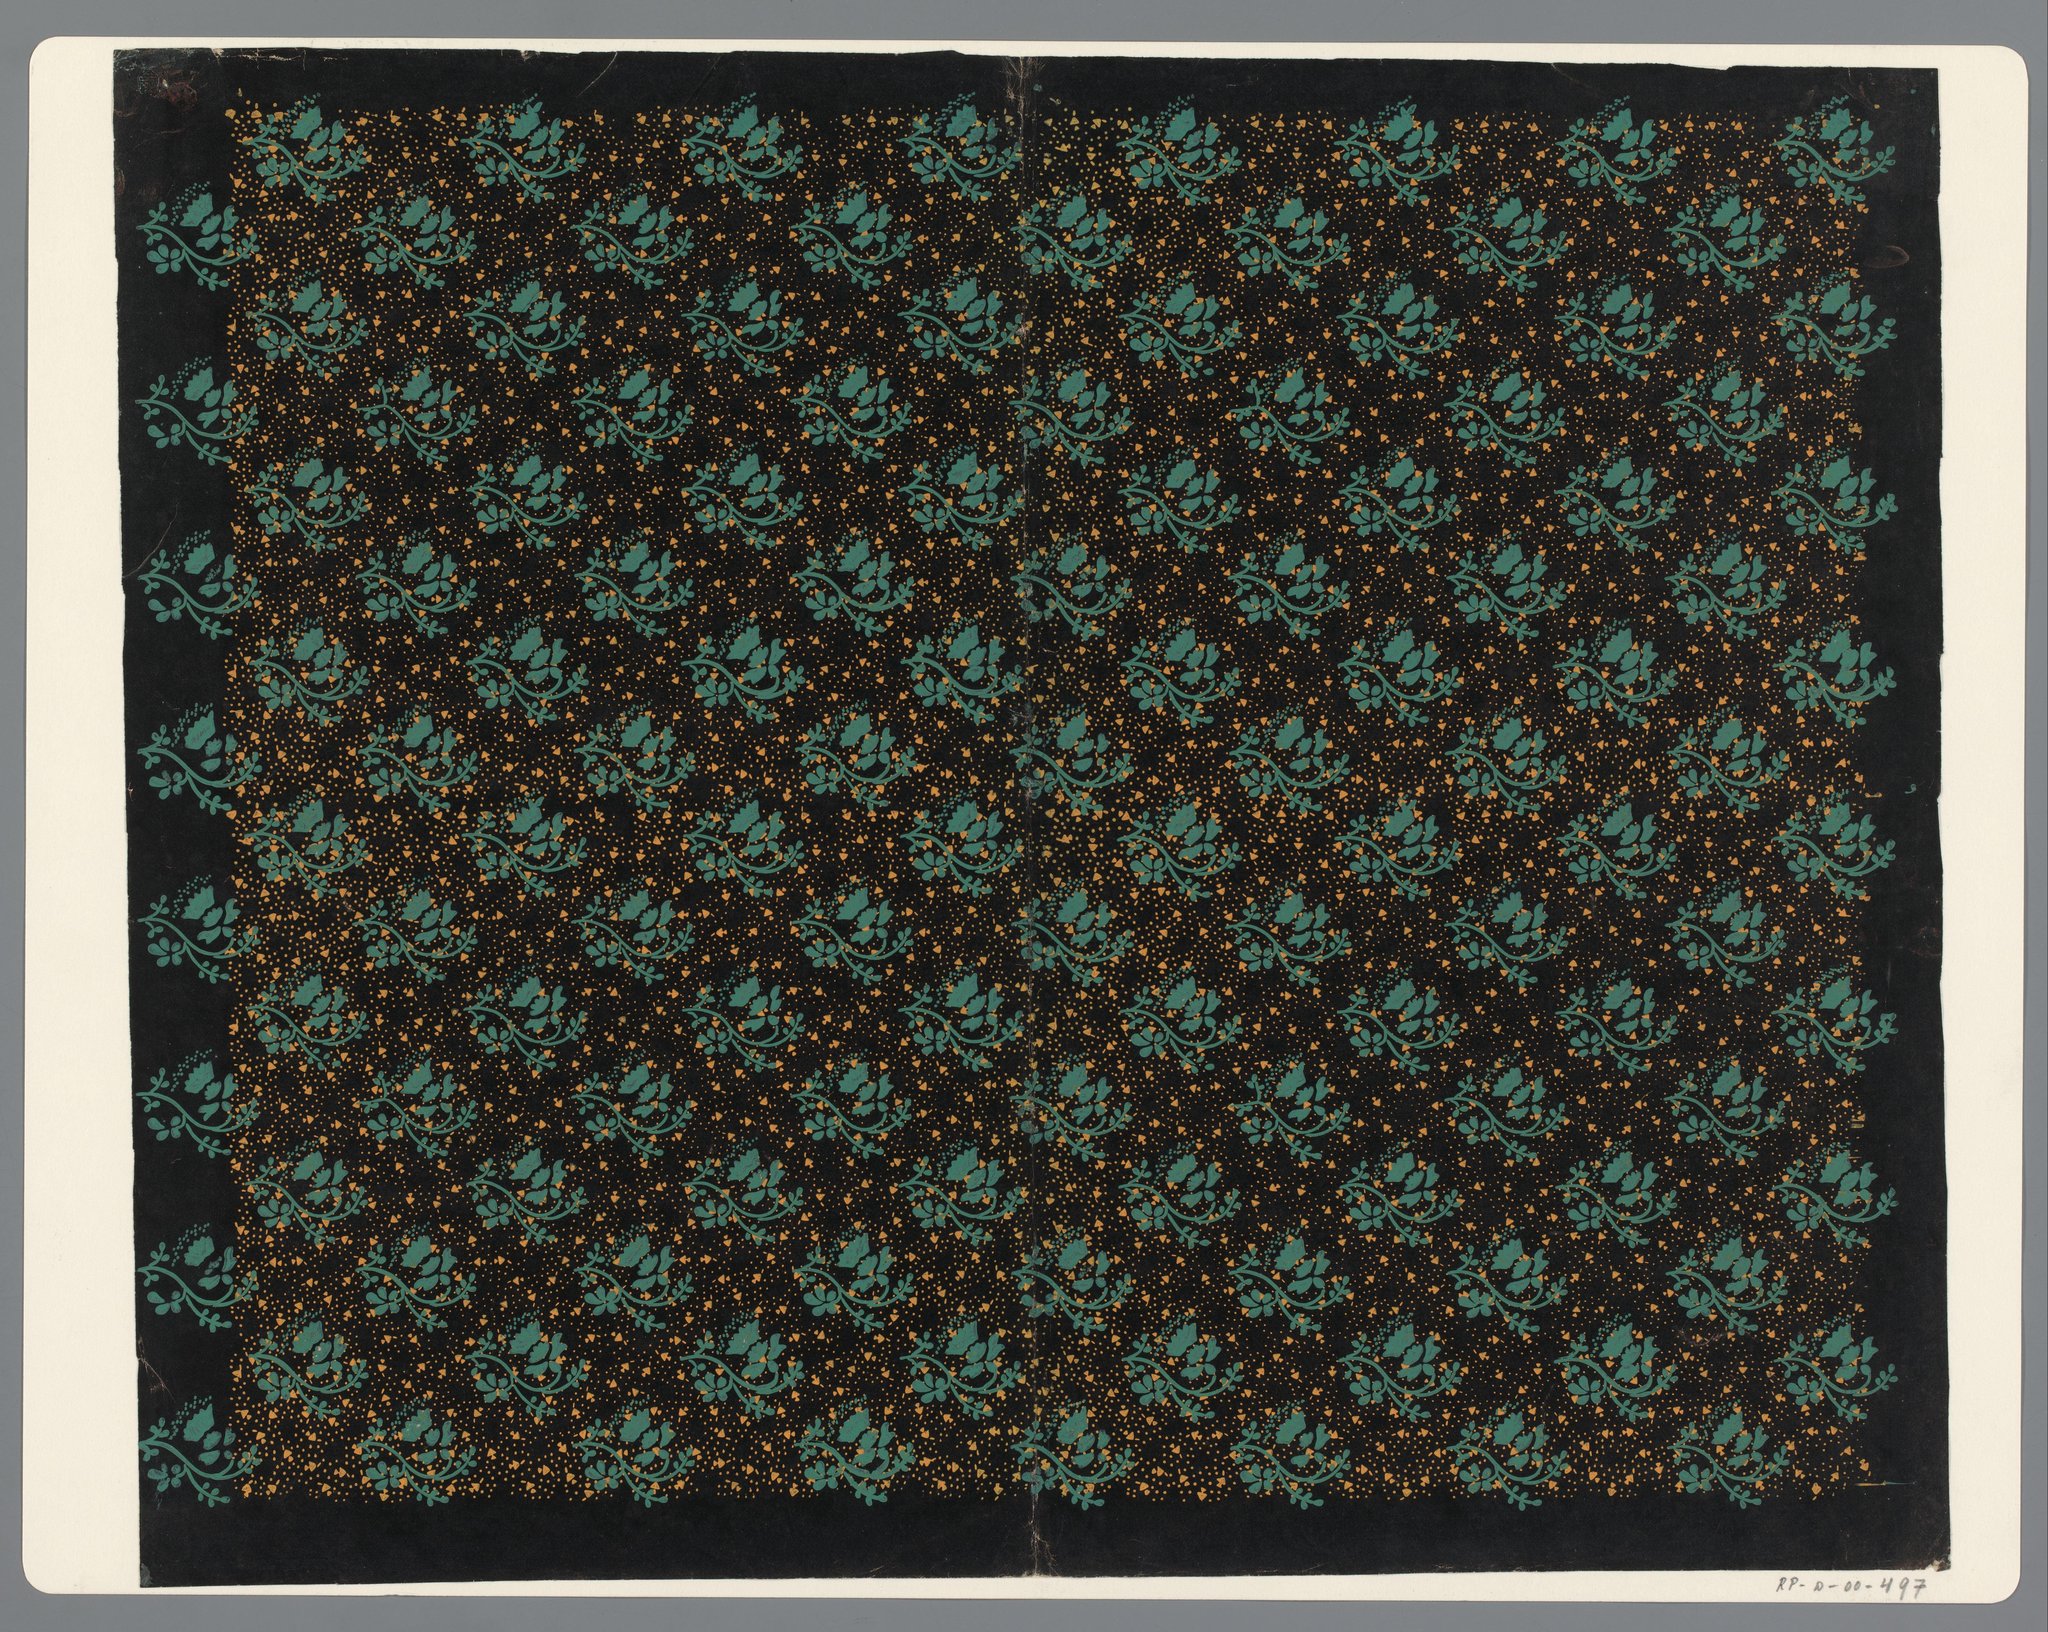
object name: wrapper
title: Blad met diagonaal banenpatroon van bloemen over een fond van kleine stippen en driehoeken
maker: Anonymous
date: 1800-1900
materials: paint, paper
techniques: printing block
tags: ornament derived from plant forms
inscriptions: collector's mark: Lugt 2228, collector's mark: Lugt 2760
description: Blad met diagonaal banenpatroon van bloemen over een fond van kleine stippen en driehoeken. Gebruikt als omslag.